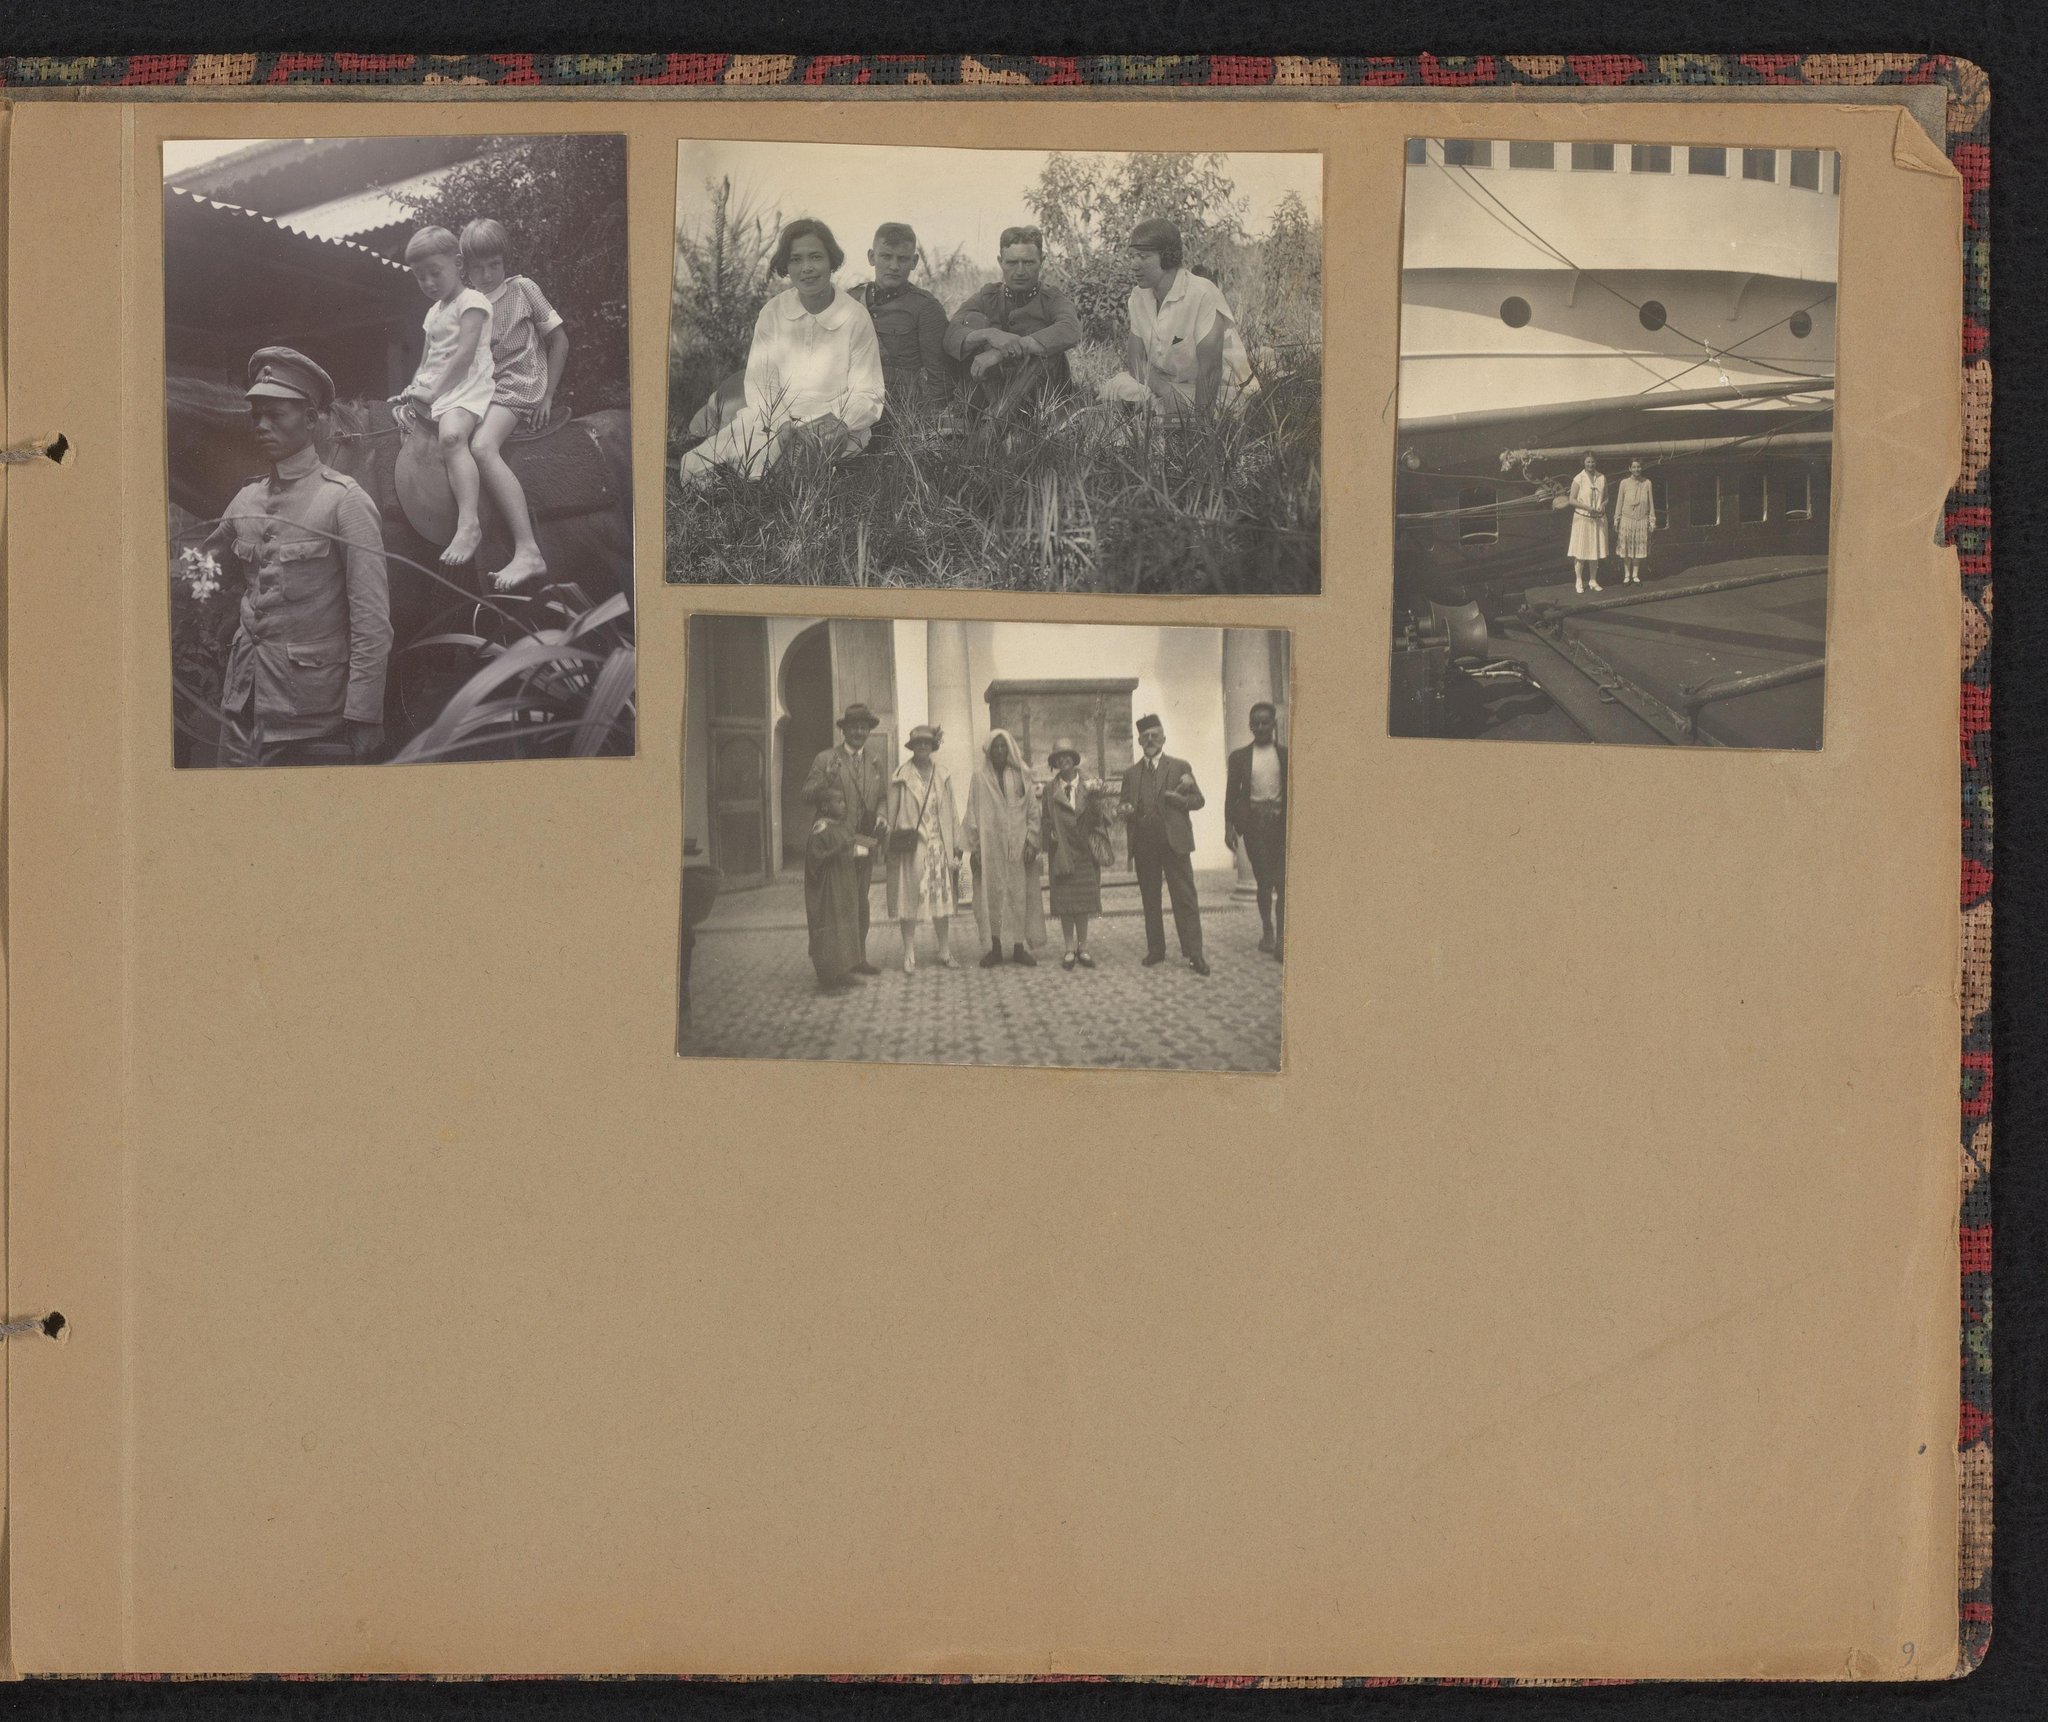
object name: album leaf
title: Blad met foto's van een vakantie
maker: Anonymous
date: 1920-1927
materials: cardboard, photographic support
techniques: gelatin silver print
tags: amsterdam, max nord, the family travelling, on holiday, outing, pleasure trip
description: Albumblad met vier foto's van een familieuitje of vakantie. Onderdeel van het fotoalbum van mevr. Nord-Elshout, de oma van de schenkster Emilie Nord (moeder van Max Nord), met foto's van familieleven uit de periode 1920-1927 in Nederlands-Indië en Nederland.